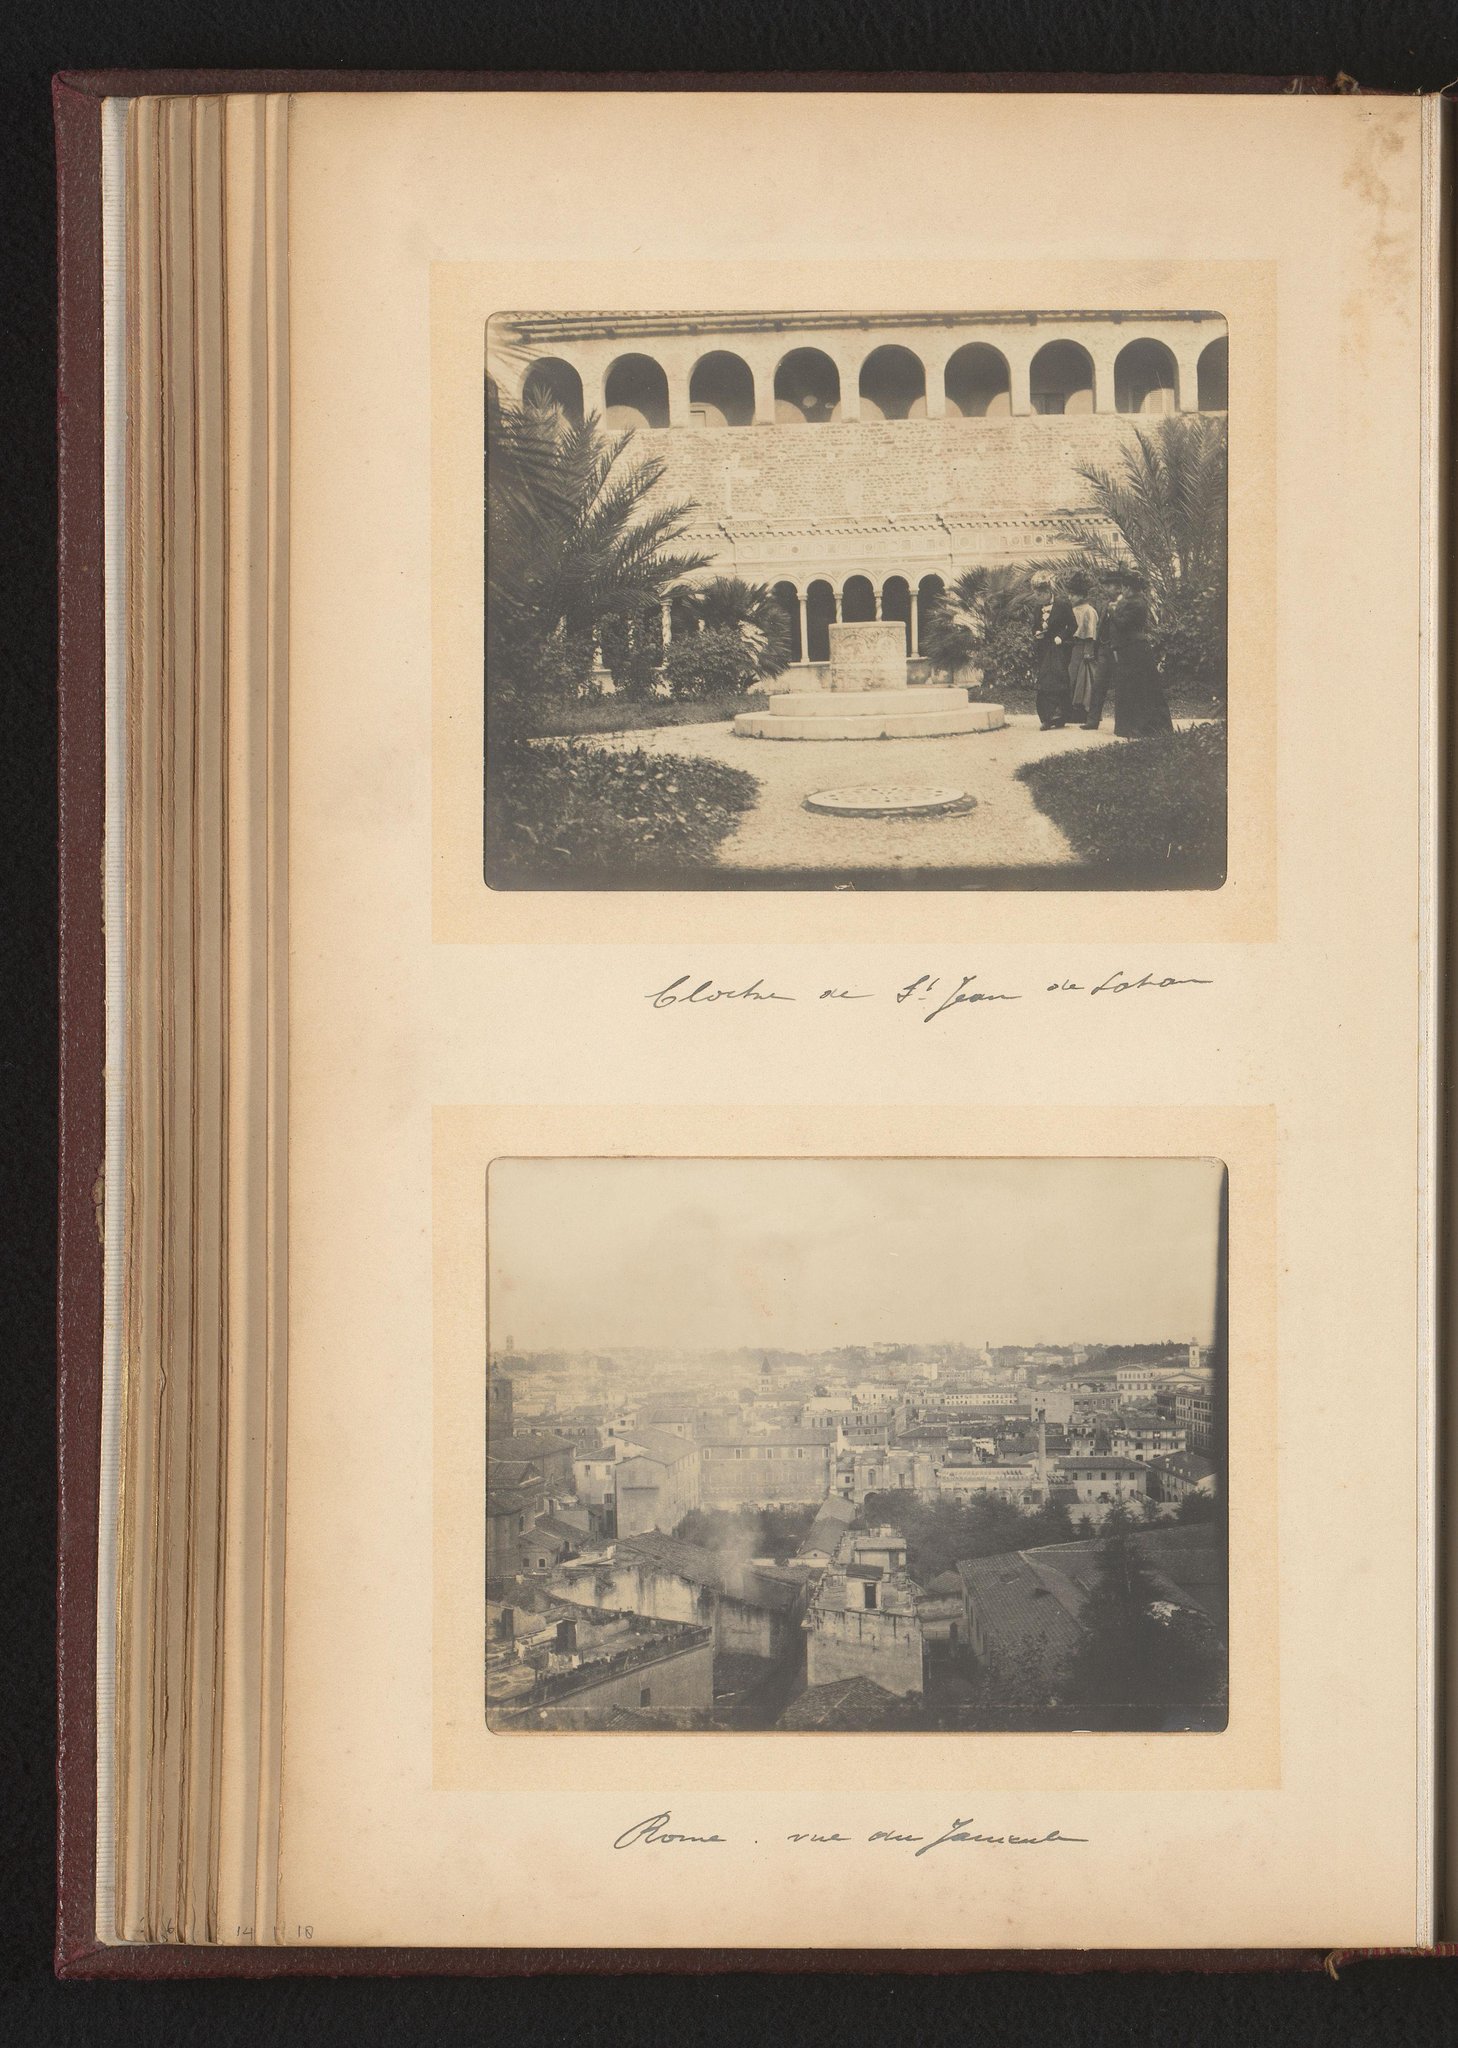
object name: photograph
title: Sint-Lan van Lateranen en het Capitool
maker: Anonymous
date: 1895-1905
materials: cardboard, photographic support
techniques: gelatin silver print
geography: rome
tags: tourism, church (exterior), rome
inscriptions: inscription: ‘St Jean de Latran, portail principal / Palais du Senat (Capitole)’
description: Albumblad met twee foto's in Rome. Onderdeel van een fotoalbum van een reis door Italië, ca. 1900.